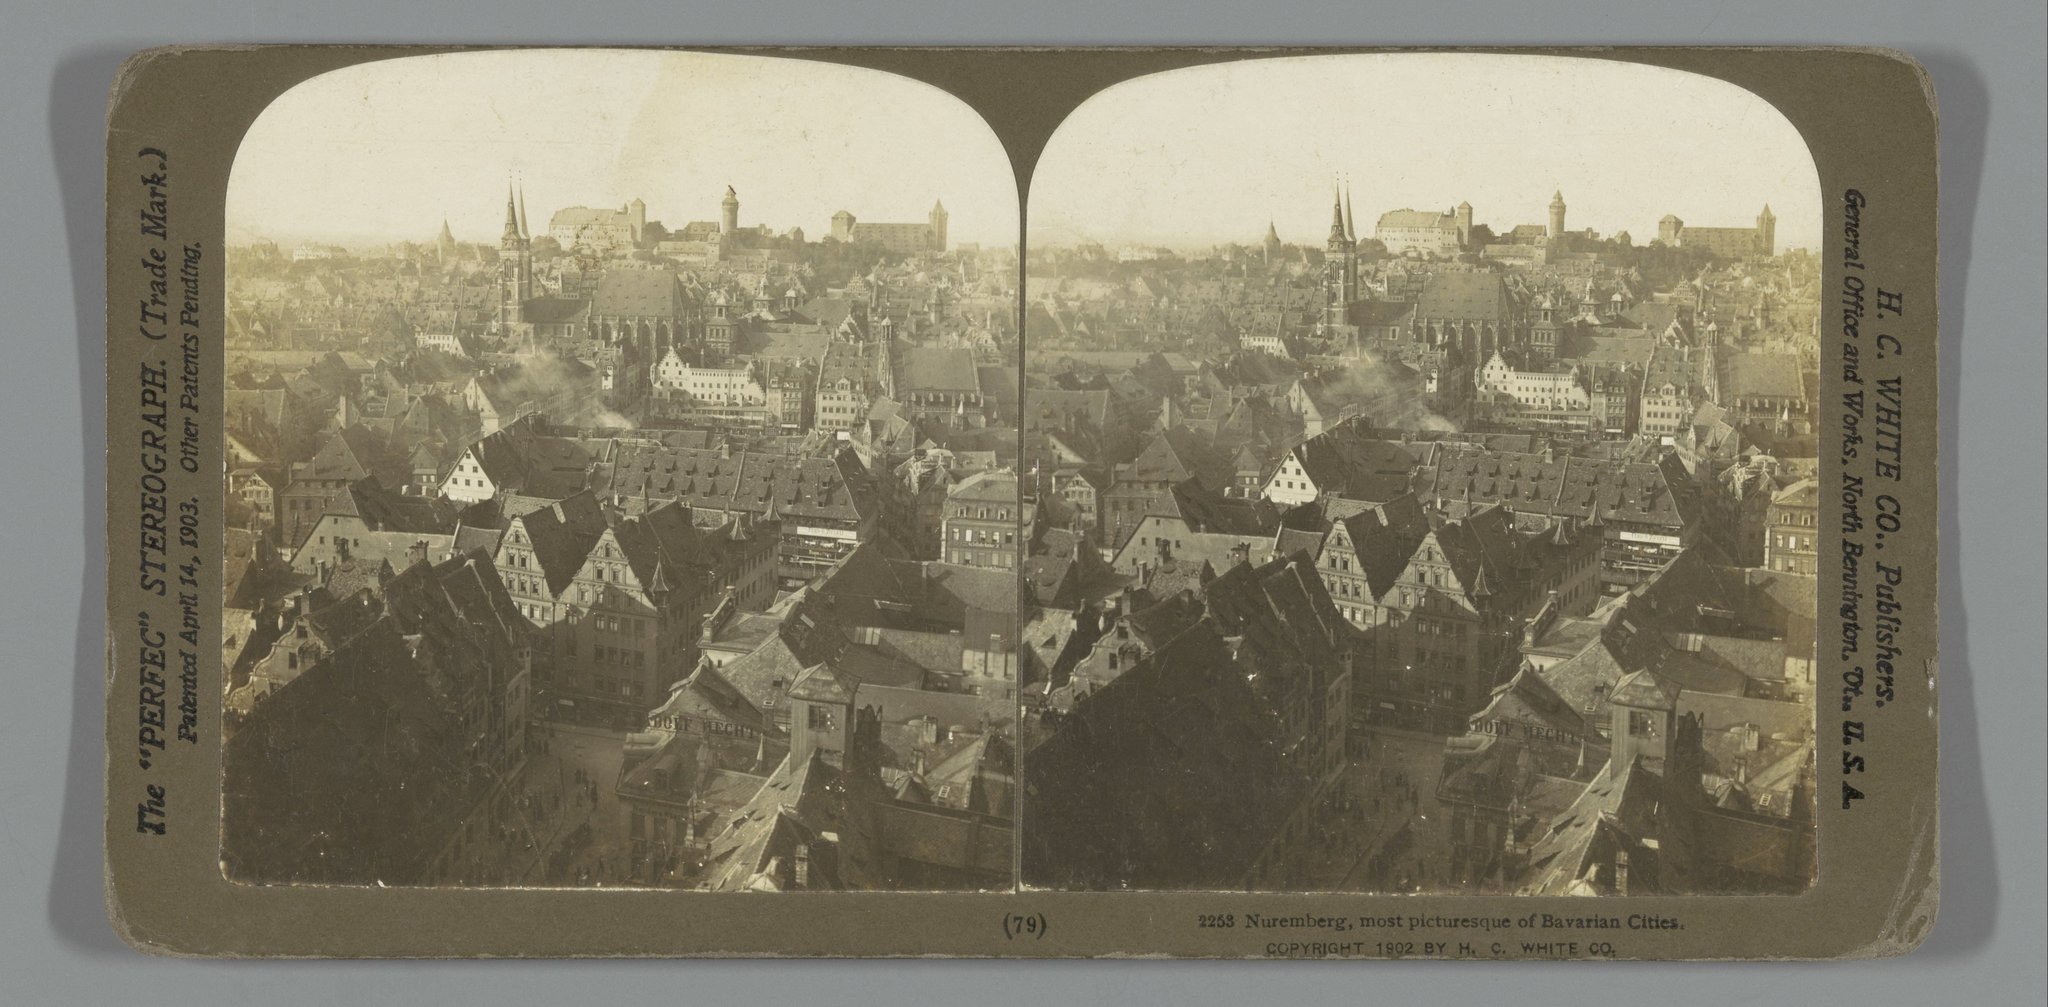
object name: stereograph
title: Nuremberg, most picturesque of Bavarian Cities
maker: h.c. white & co. publishers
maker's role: fotograaf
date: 1903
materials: cardboard, photographic support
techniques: gelatin silver print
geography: united states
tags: city-view in general; 'veduta'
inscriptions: number: ‘2253’